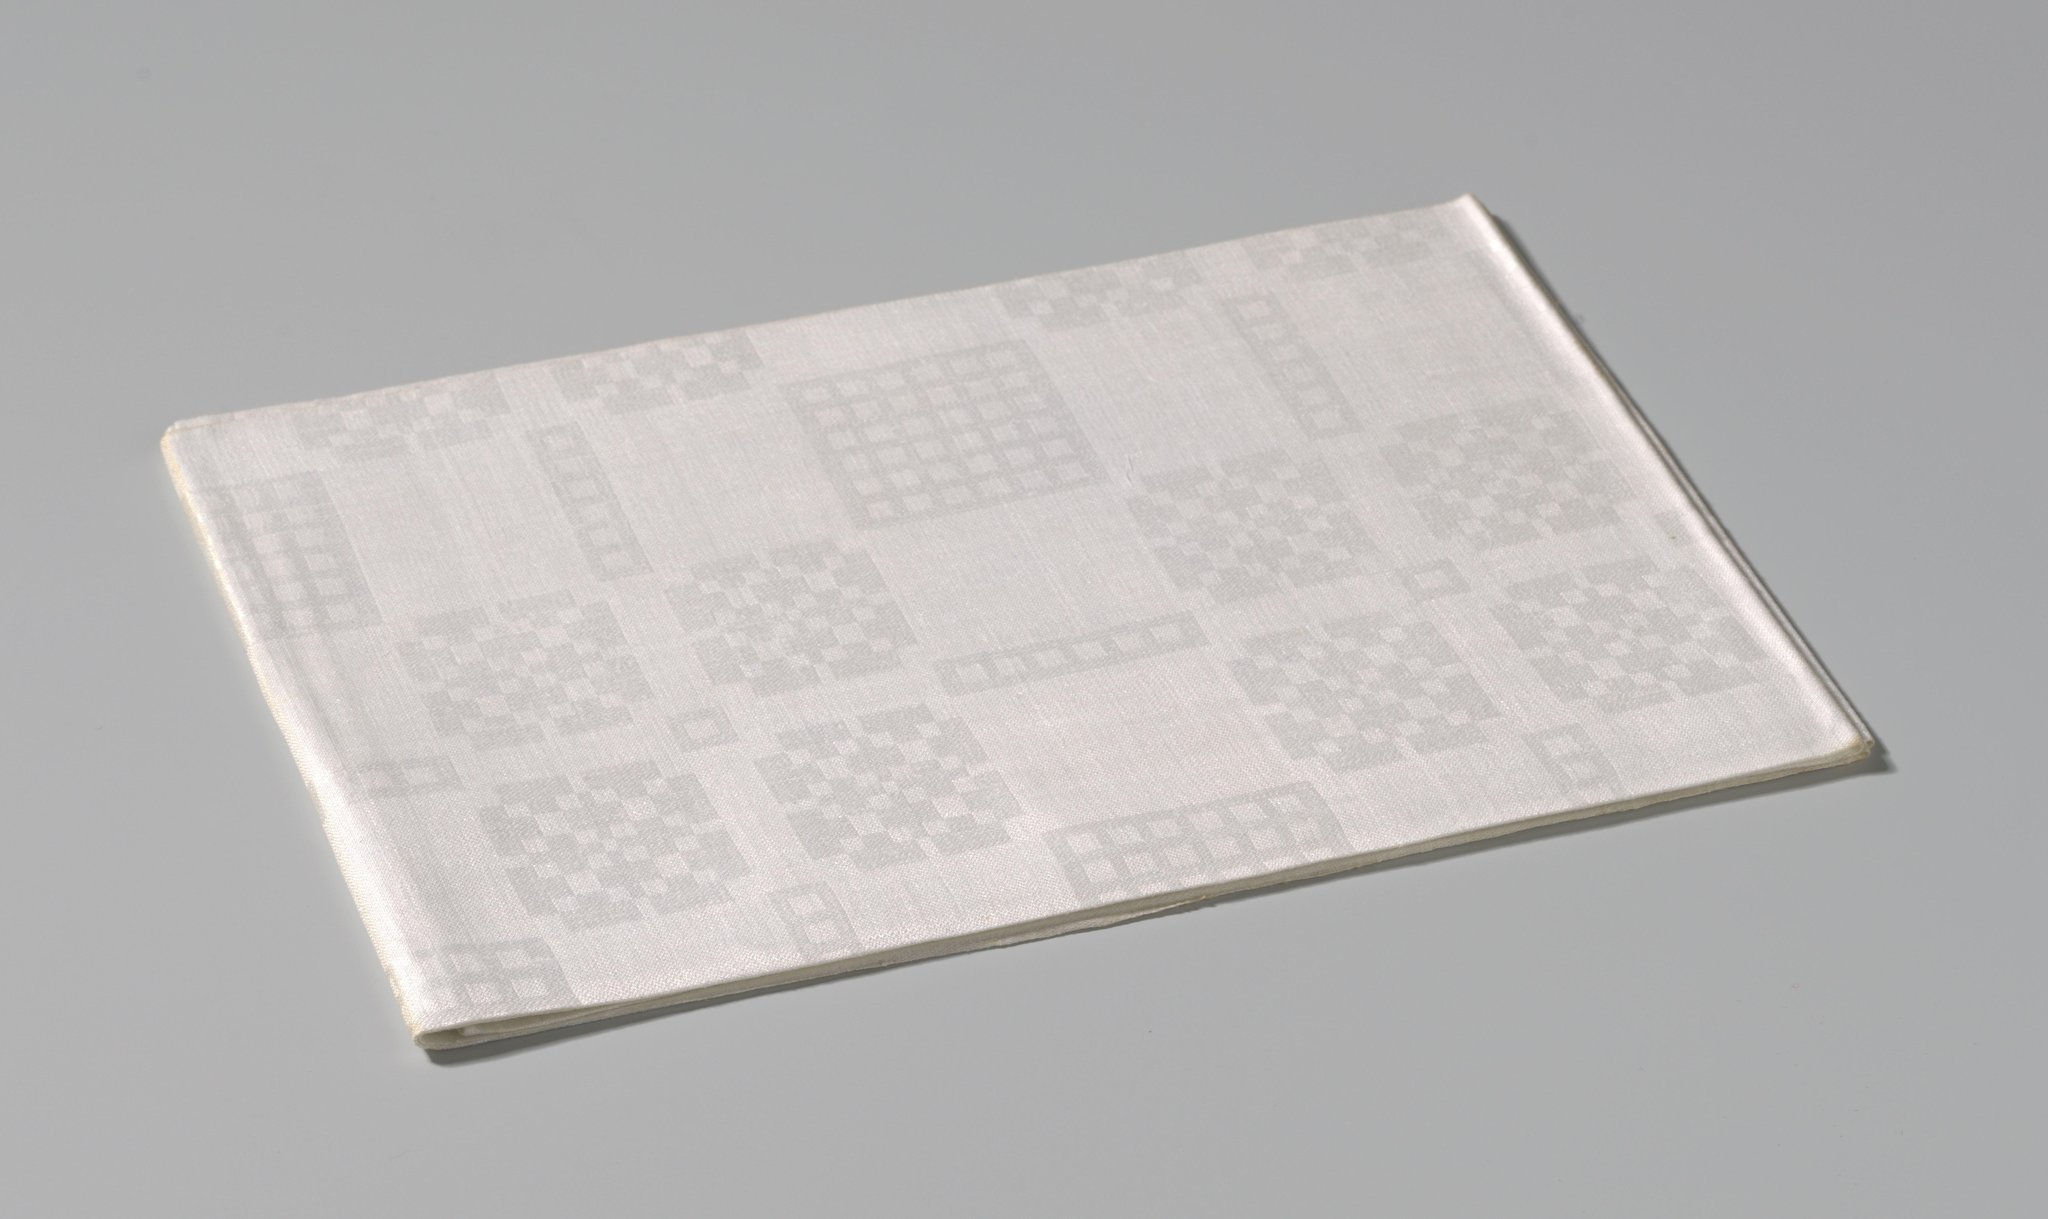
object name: napkin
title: Servet van linnen met pellenpatroon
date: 1400-1950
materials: linen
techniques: peeled fabric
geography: northern netherlands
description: wit linnen servet met pellen patroon, merk IS en 47